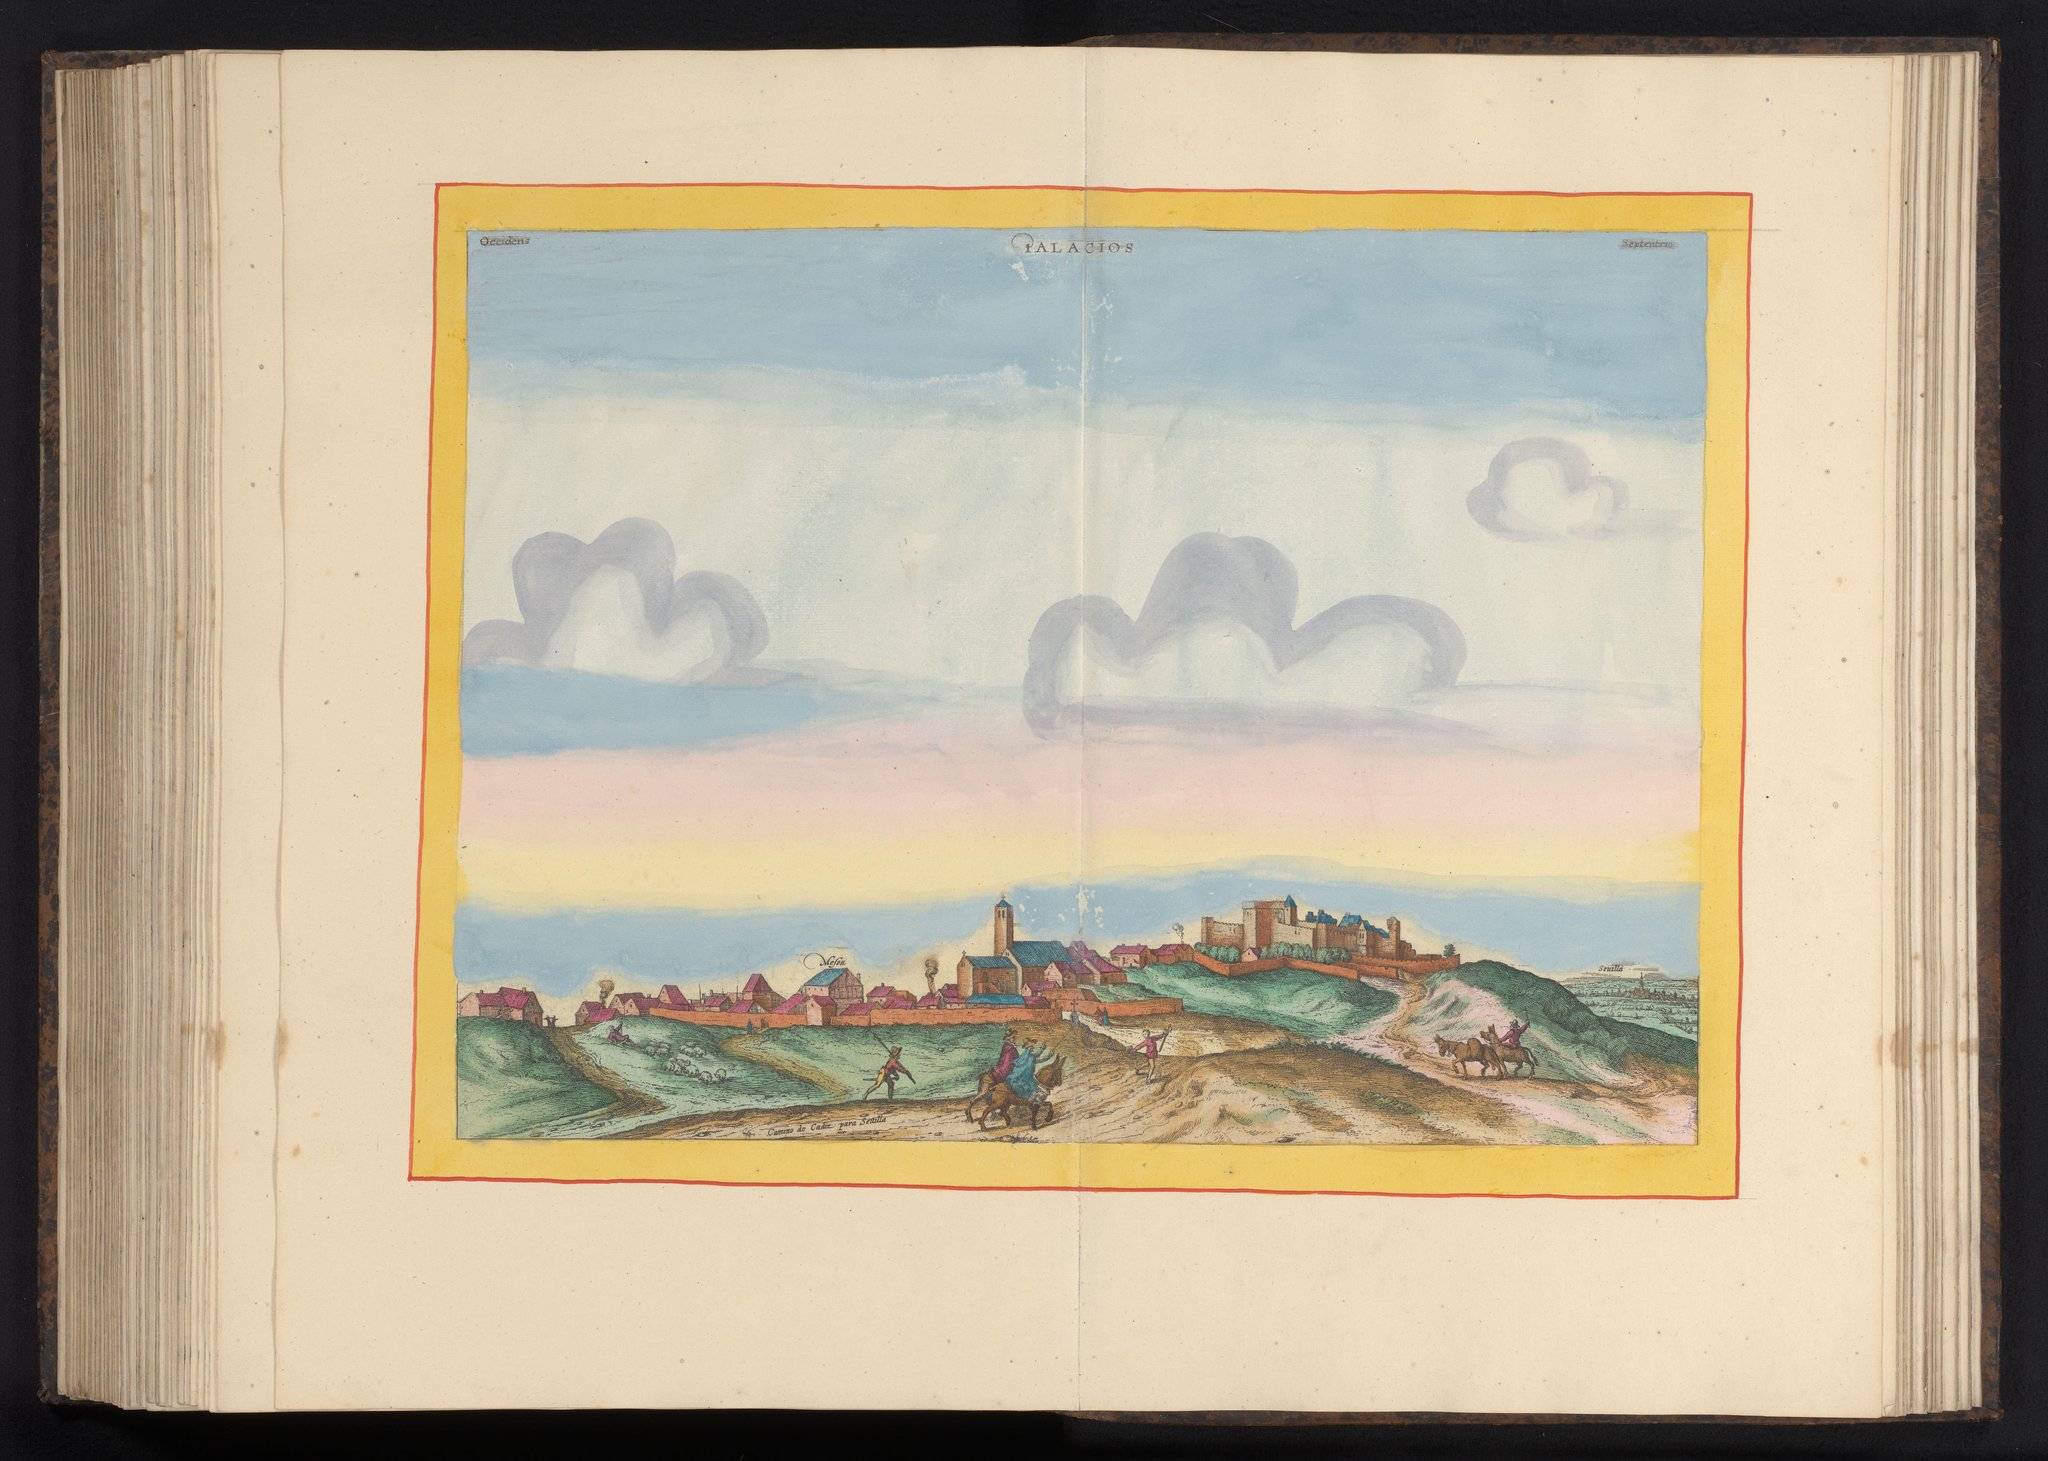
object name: print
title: Gezicht op de ommuurde stad Los Palacios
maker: anna beeck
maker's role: publisher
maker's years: 1657-1717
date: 1596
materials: paper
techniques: engraving, etching, hand coloring, letterpress printing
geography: the hague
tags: prospect of village, silhouette of village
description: Prent origineel vervaardigd als boekillustratie voor: Georg Braun en Frans Hogenberg. Civitates Orbis Terrarum, 6 delen. Keulen: 1572-1617. De prent werd voor het eerst gepubliceerd in deel 5: Urbium praecipuarum mundi theatrum quintum, 1596. De prent is langs de bovenrand van de voorstelling afgescheurd. Het bovenste gedeelte is hoger opgeplakt, zodat de lucht hoger is geworden en het formaat van de voorstelling past bij de andere groot formaatvoorstellingen in het album.